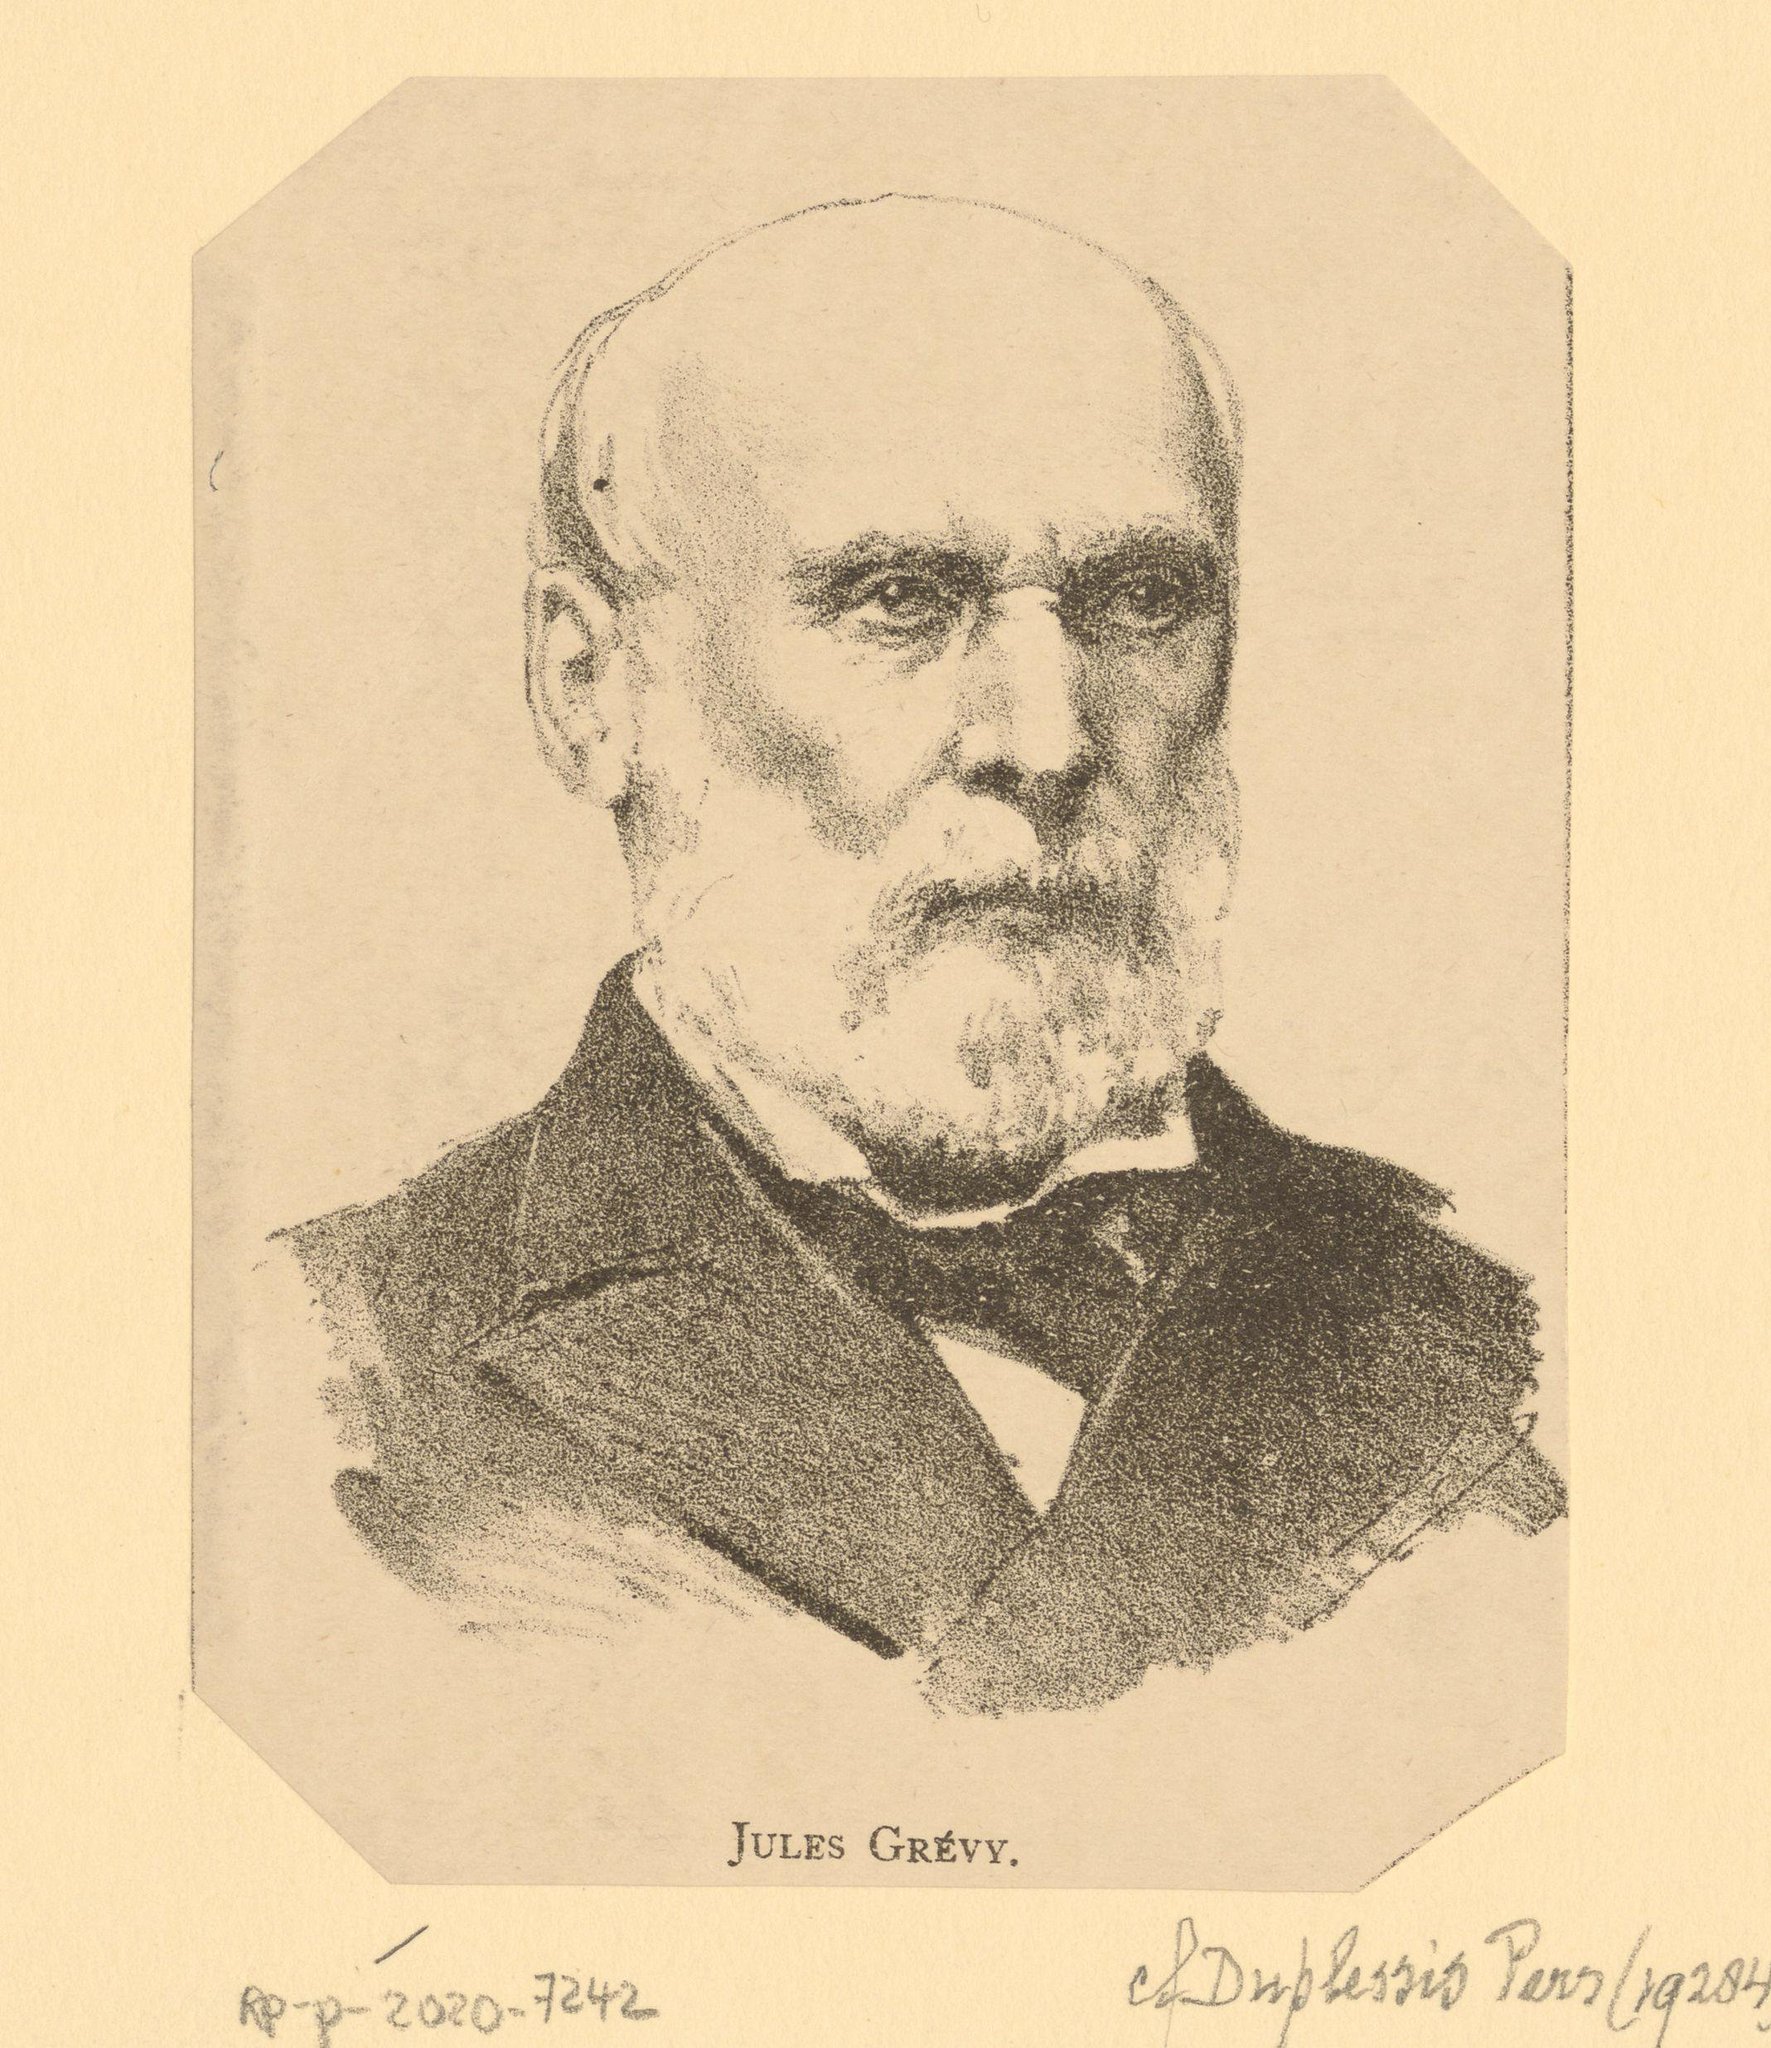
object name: print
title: Portret van Jules Grévy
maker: Anonymous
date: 1850-1900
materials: paper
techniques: lithograph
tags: politician, president ~ head of republic, historical persons